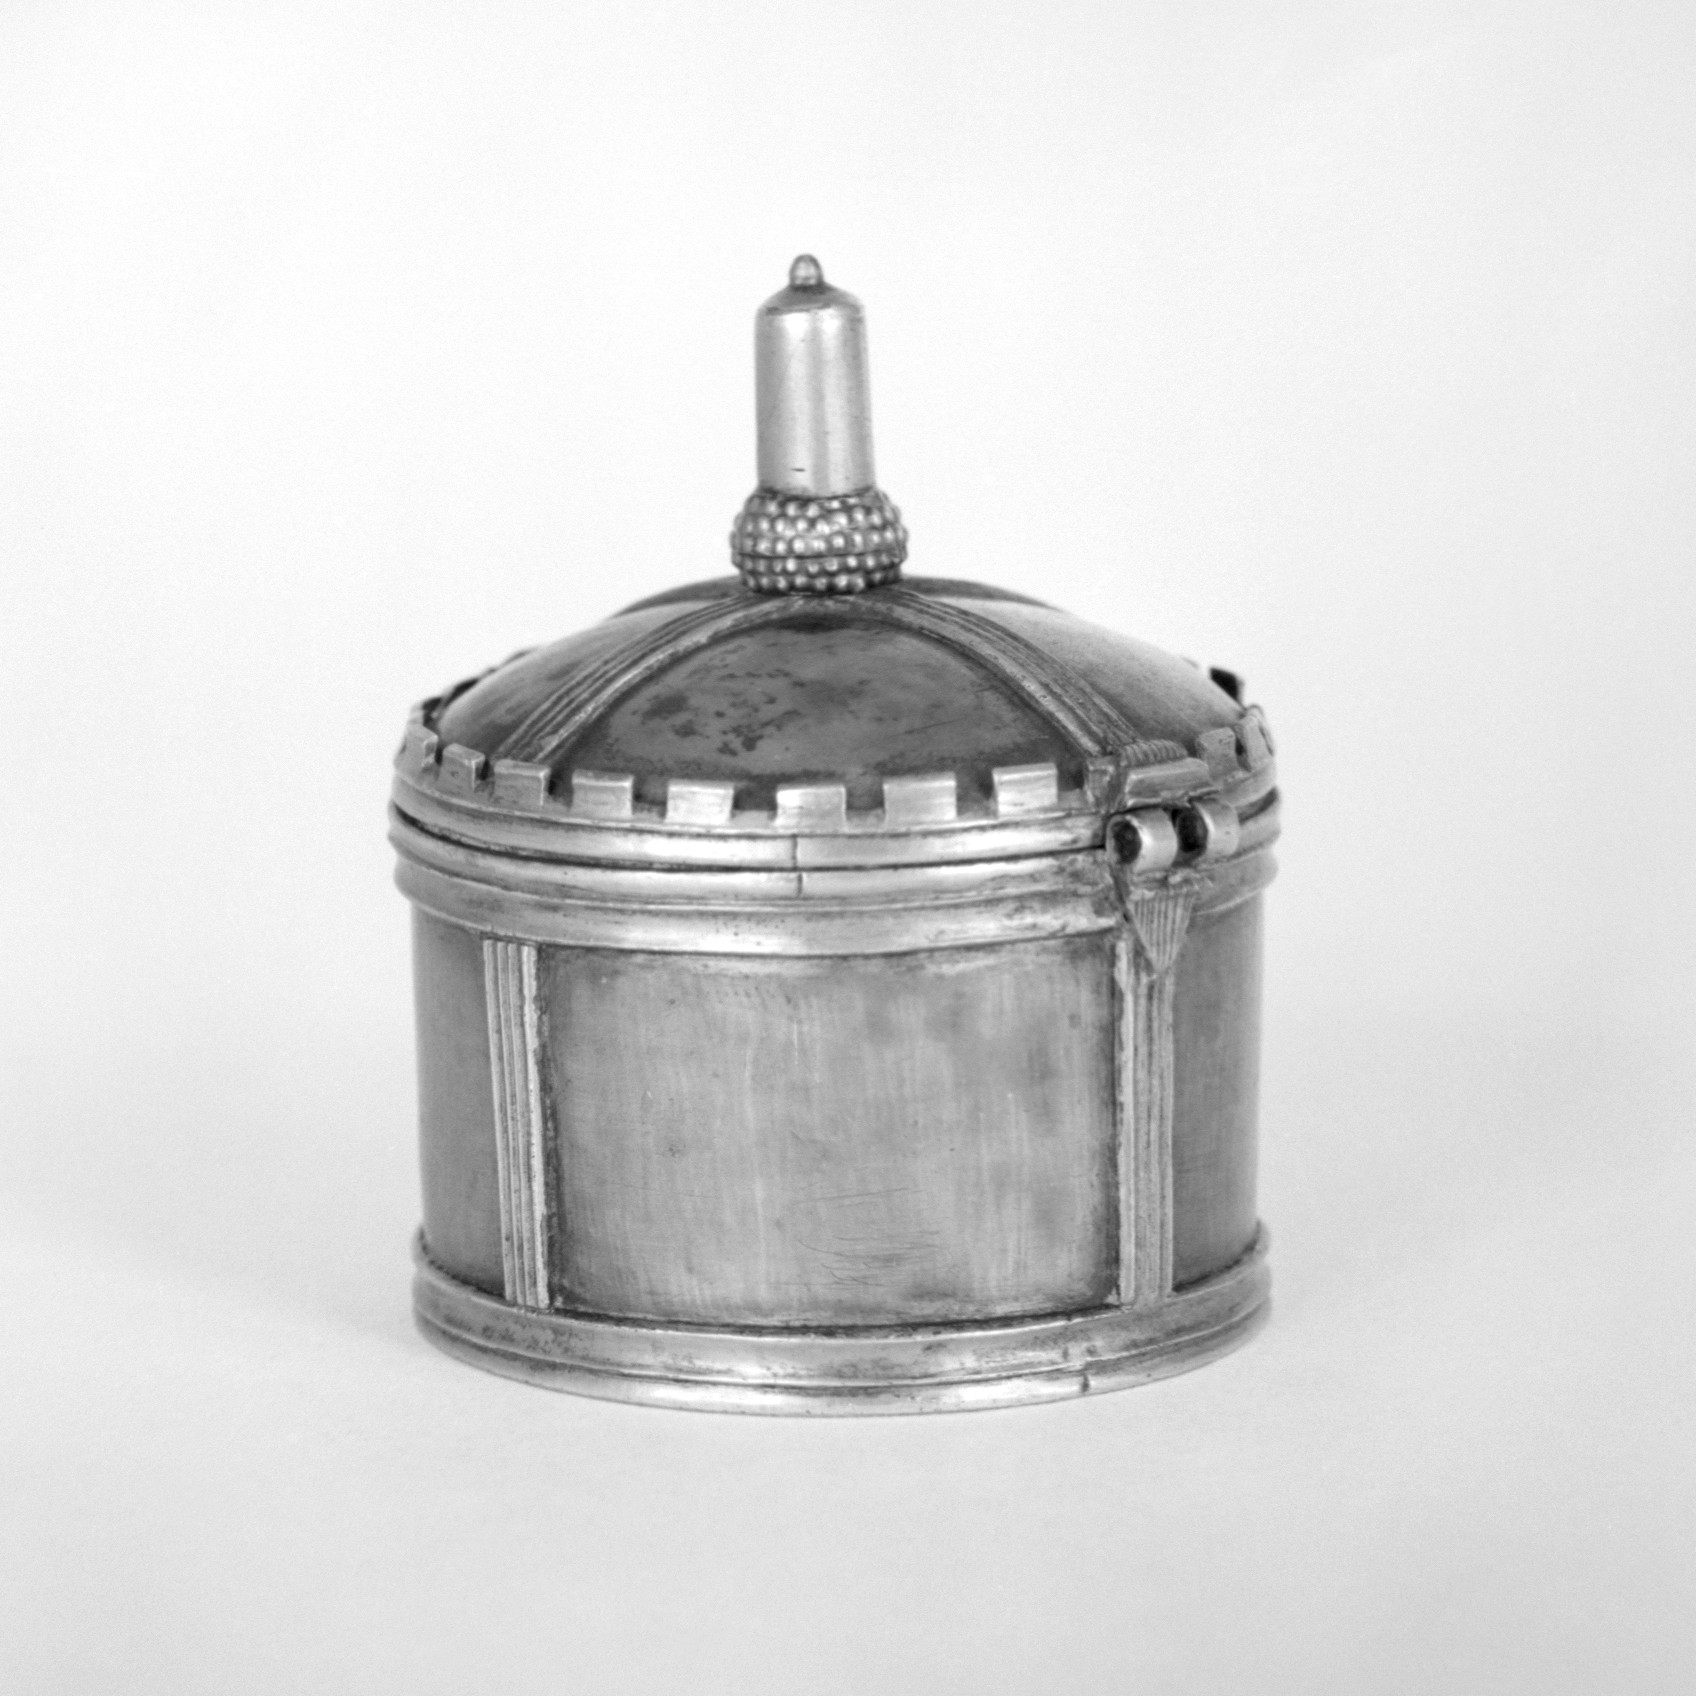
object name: box with cover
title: Circular box with hinged cover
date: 1567-1600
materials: gilt, silver